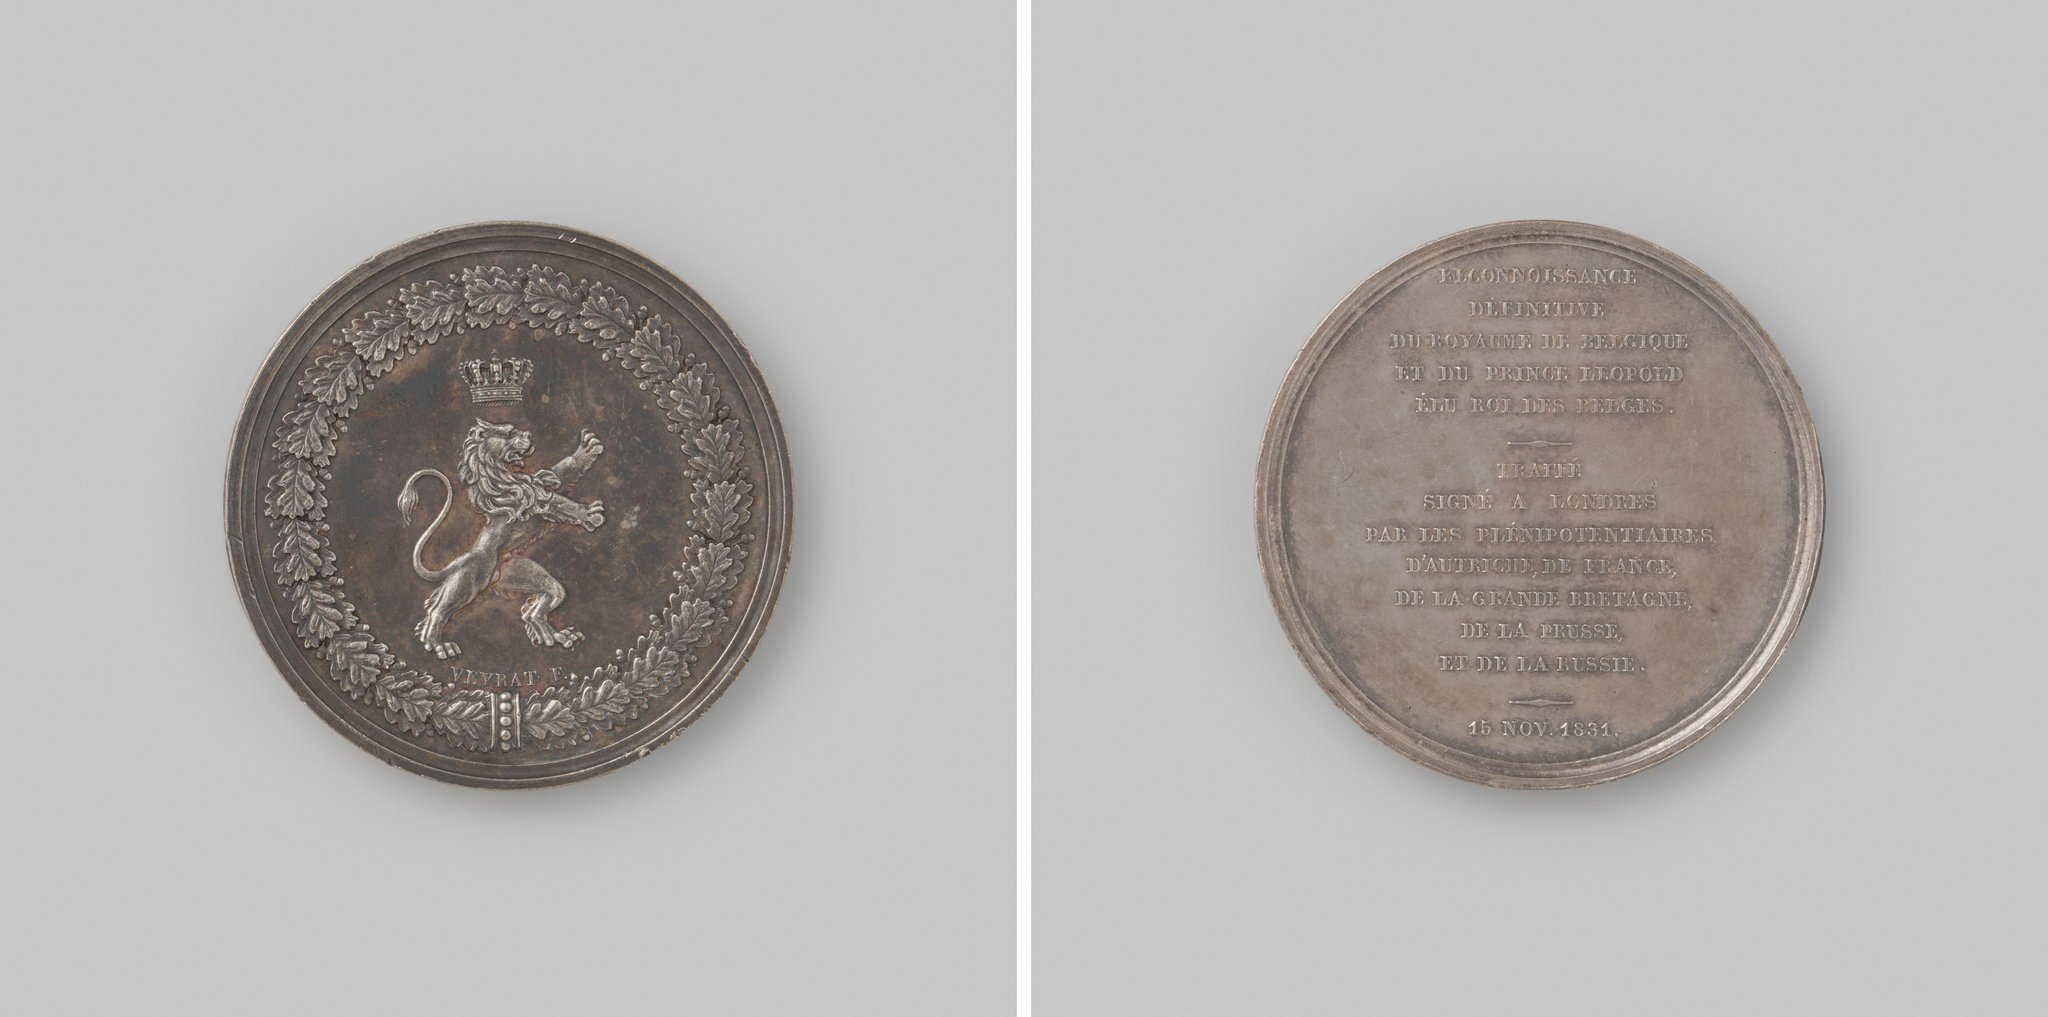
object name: history medal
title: Erkenning van de onafhankelijkeid van het koninkrijk België door de XXIV Artikelen van de conferentie van Londen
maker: adrien hippolyte veyrat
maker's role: medailleur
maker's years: 1803-1883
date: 1831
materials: silver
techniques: striking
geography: brussels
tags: leopold i (koning der belgen), london, belgium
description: Zilveren penning. Voorzijde: staande leeuw onder kroon binnen eikenkrans. Keerzijde: opschrift